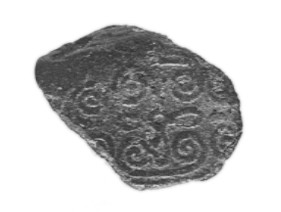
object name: sealing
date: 2030-1640 BCE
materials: clay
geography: egypt